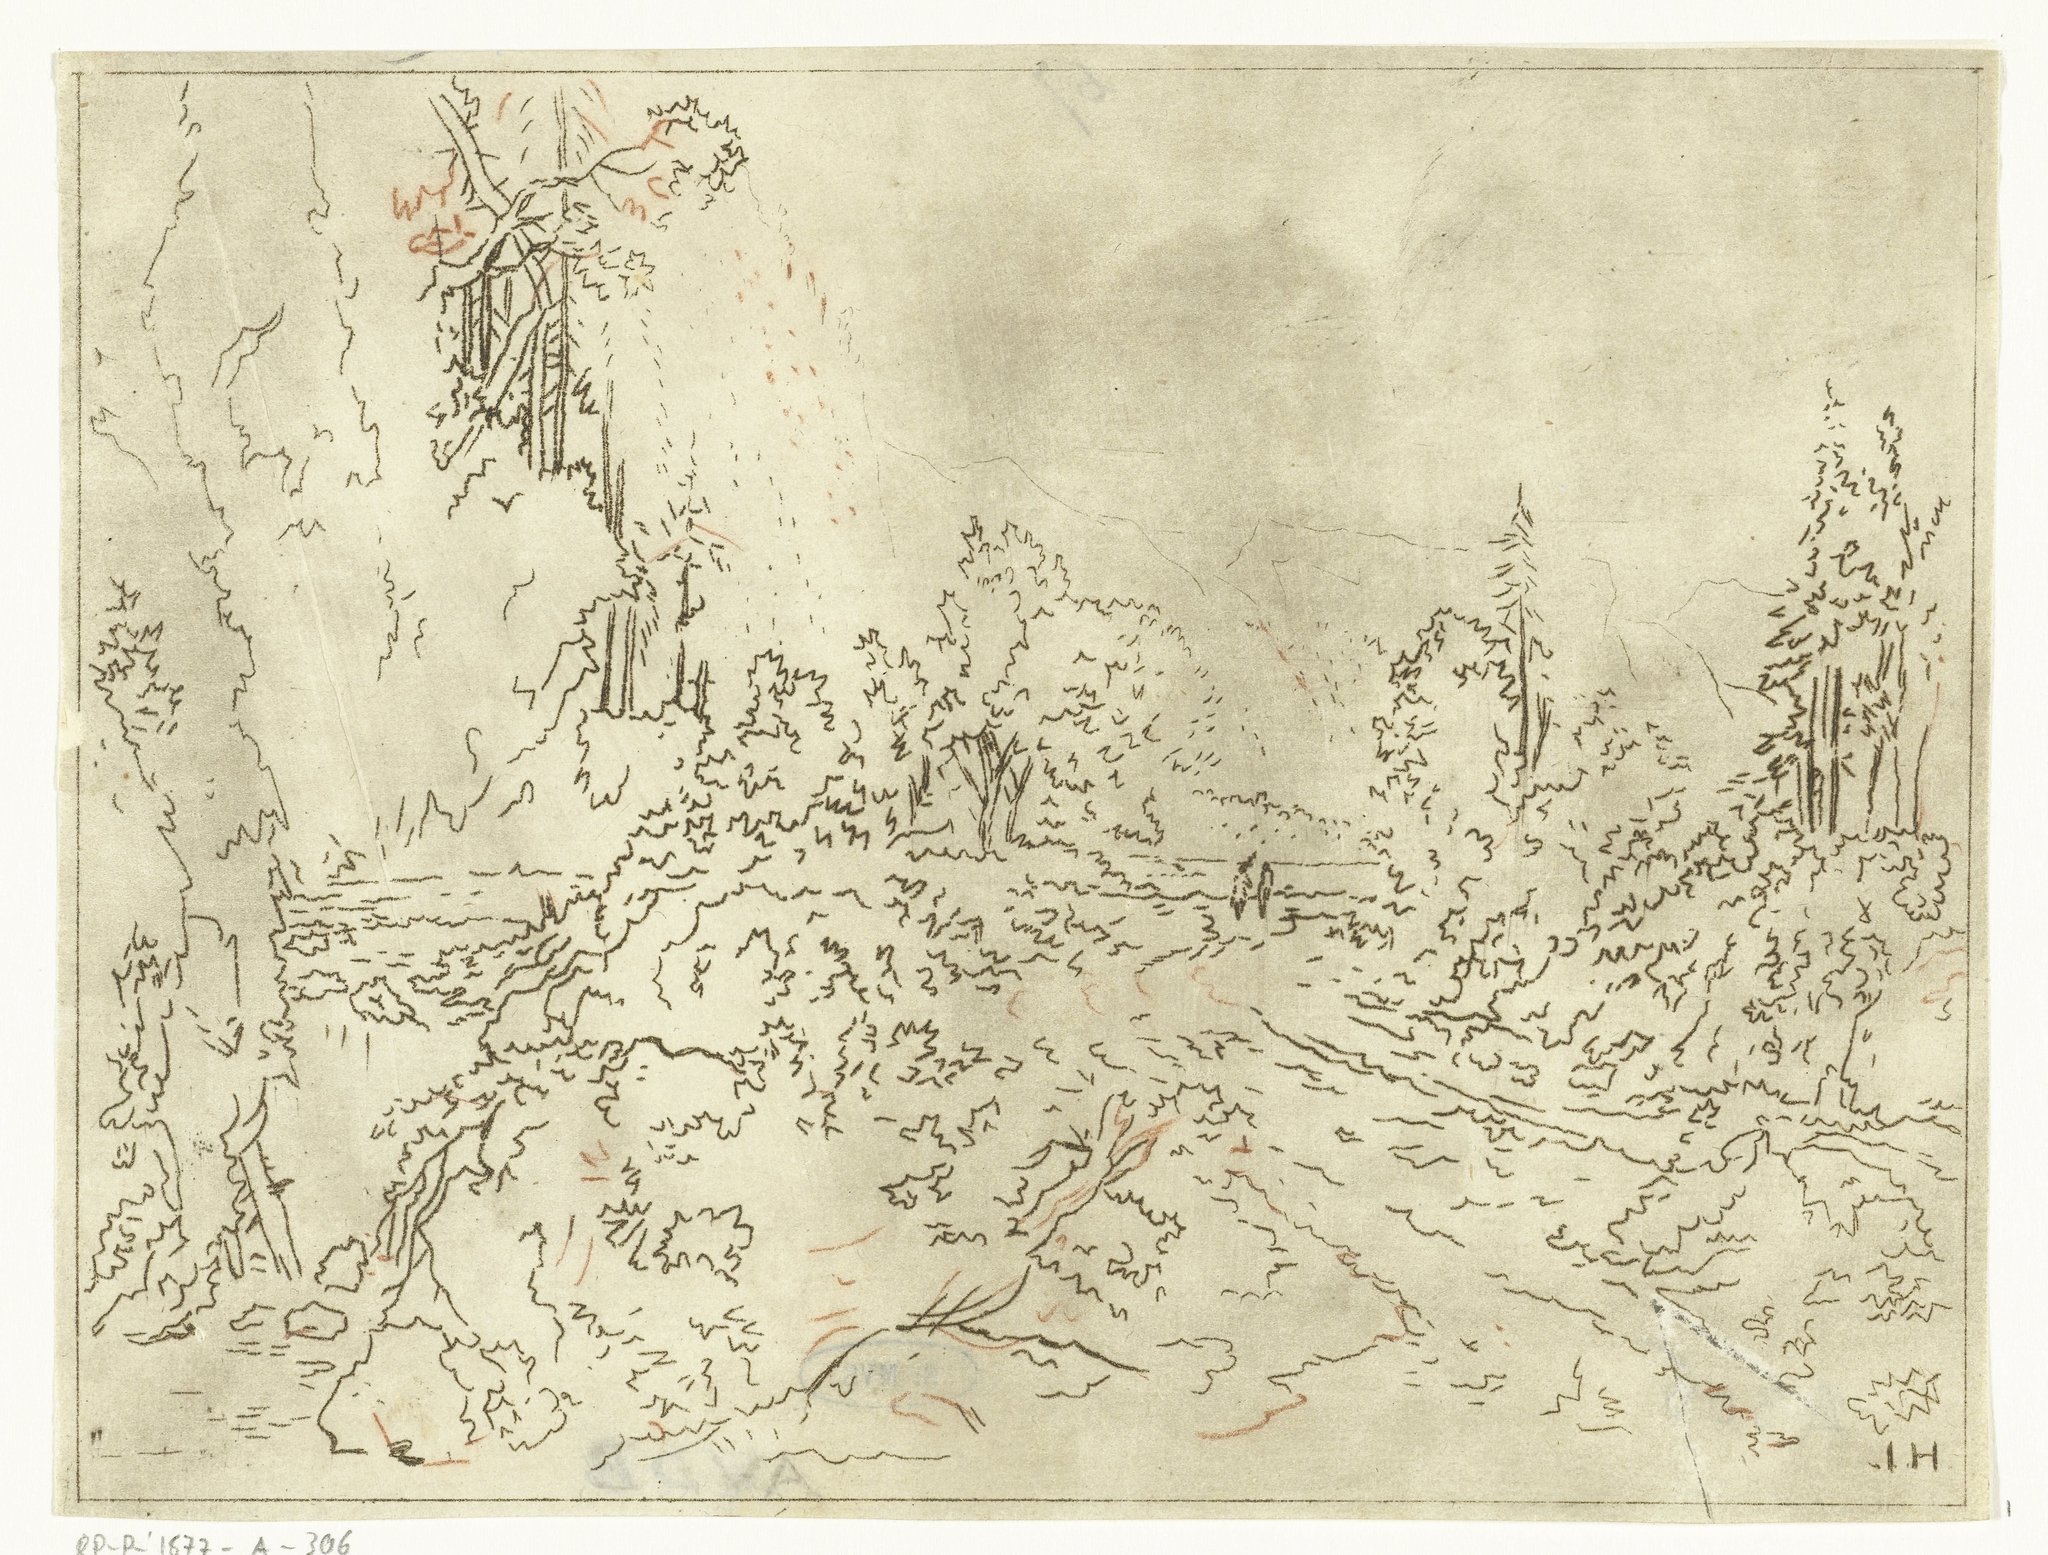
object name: print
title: Bergachtig landschap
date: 1778-1838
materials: chalk, paper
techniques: etching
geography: netherlands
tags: waterfall, dale, valley (+ landscape with figures, staffage)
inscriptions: name: ‘AVDB’, collector's mark: Lugt 2228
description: Twee wandelaars lopen op een weg door een valei. Links een waterval.